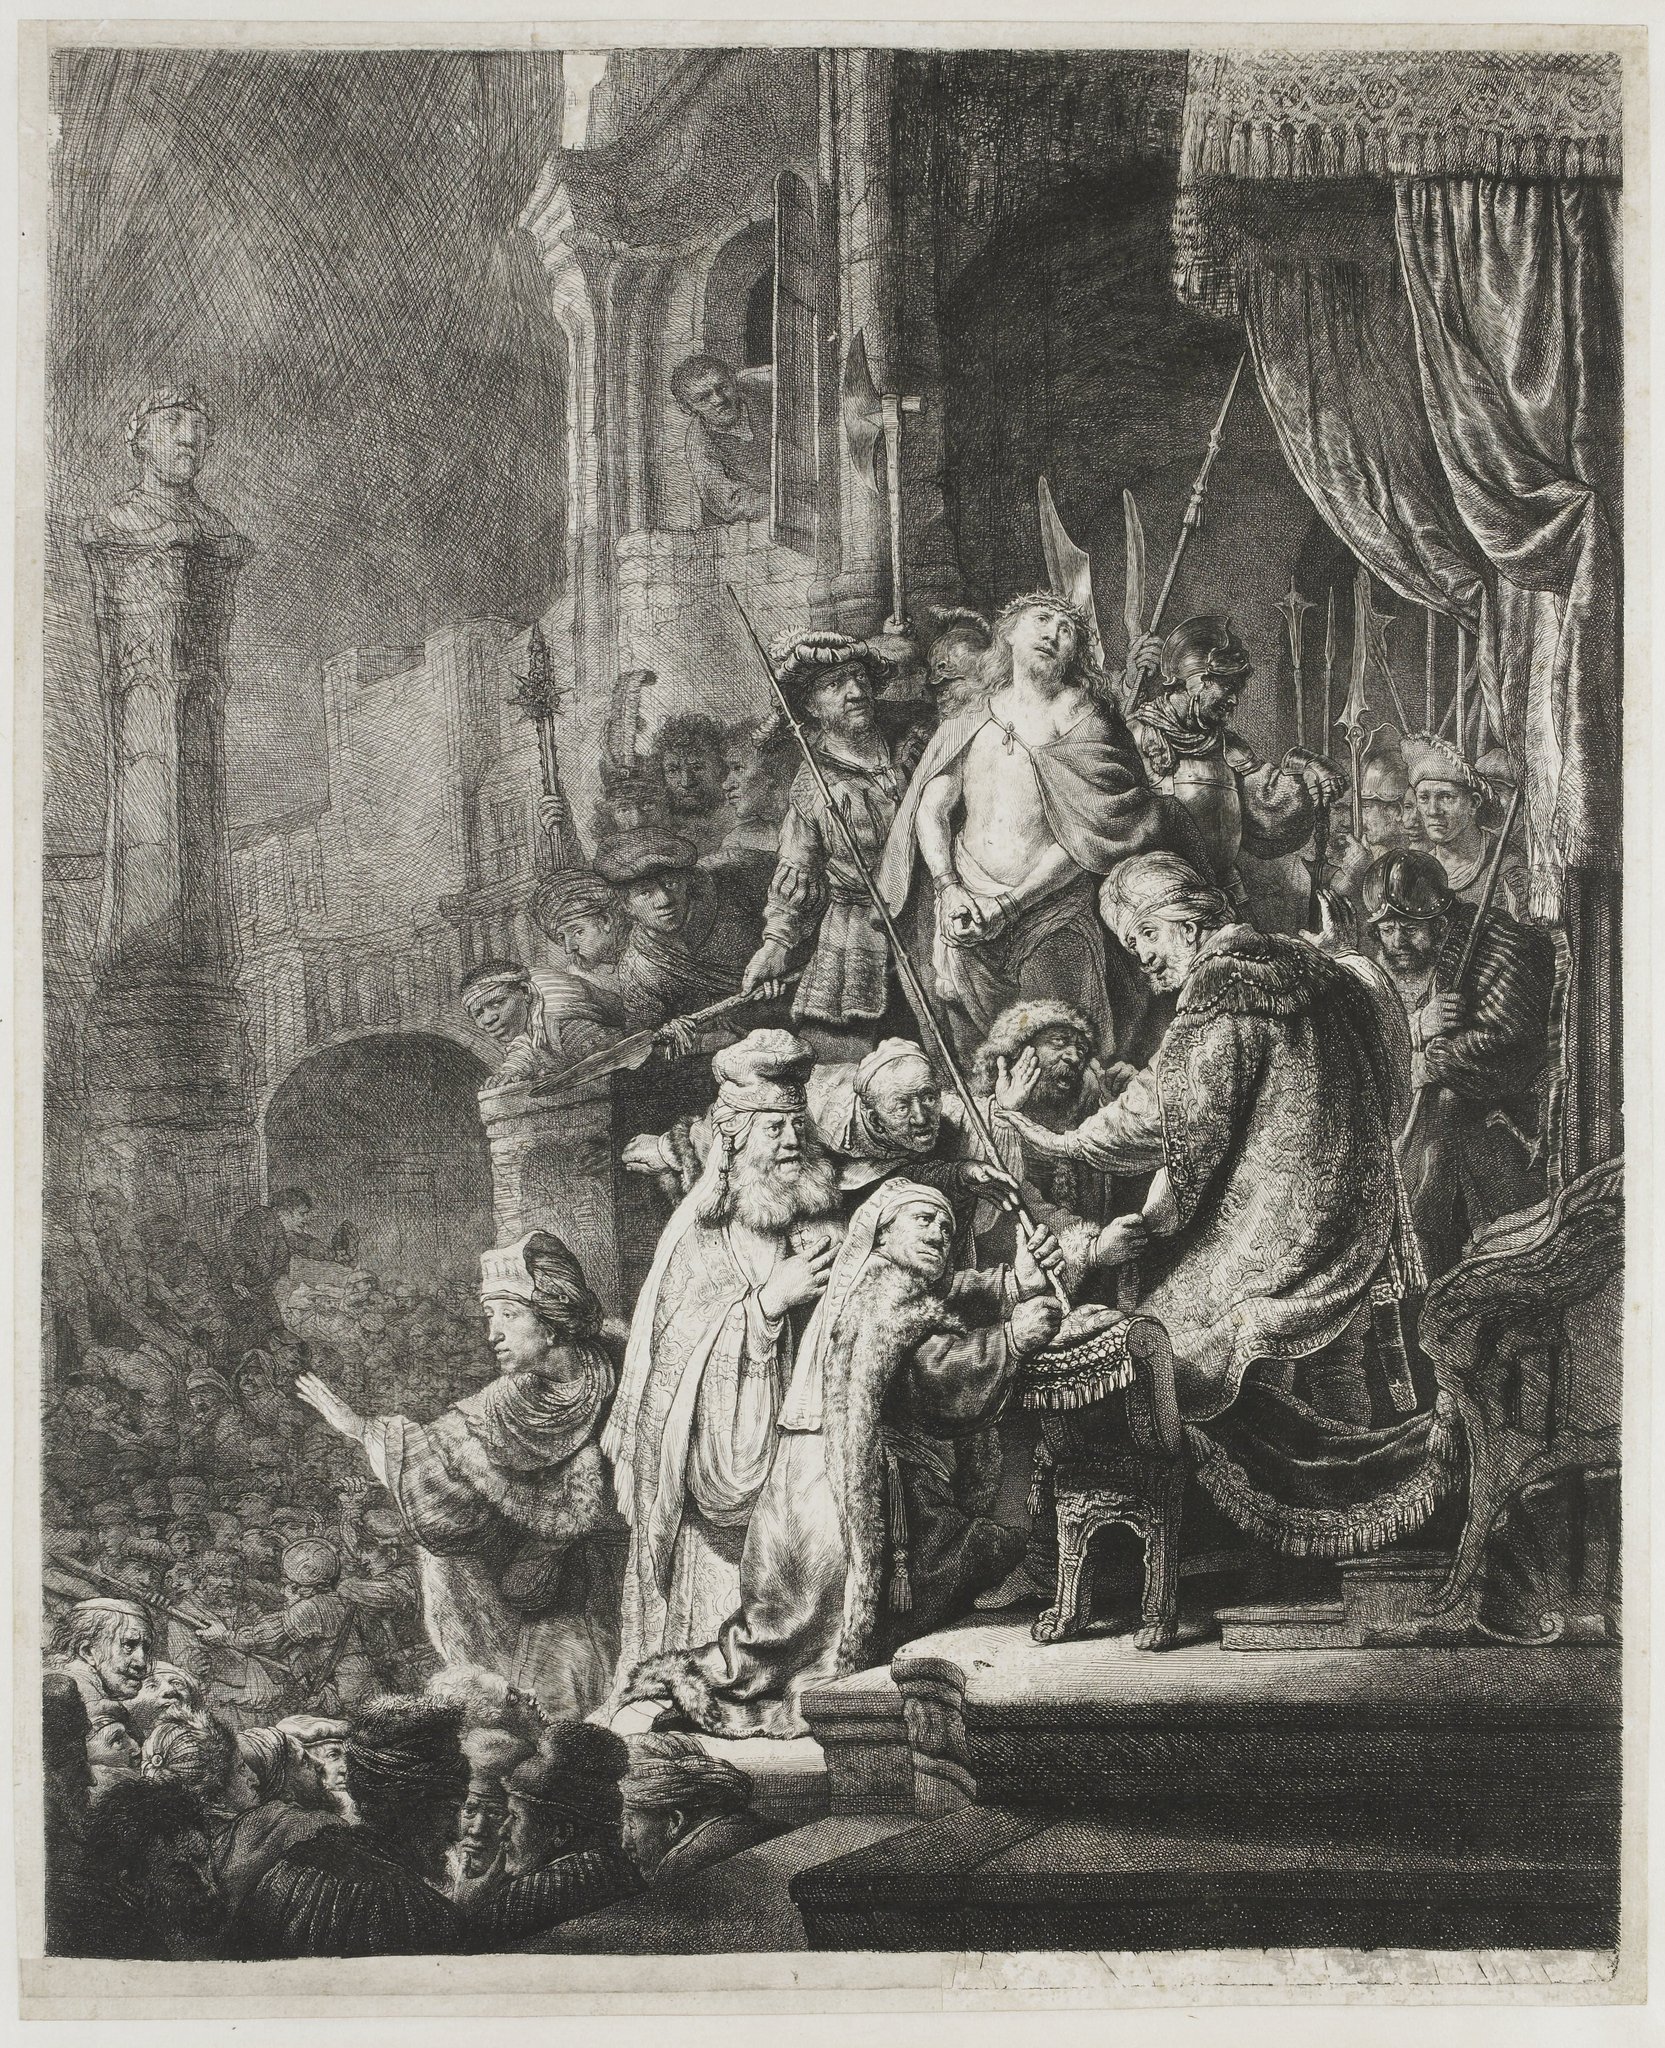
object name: print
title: Christ before Pilate: large plate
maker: rembrandt van rijn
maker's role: draughtsman, painter, print maker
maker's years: 1606-1669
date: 1635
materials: paper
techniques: etching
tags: christ before pontius pilate (matthew 27:11-26; mark 15:2-15; luke 23:2-7, 23:13-25; john 18:28 - 19:16)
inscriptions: collector's mark: Lugt 240